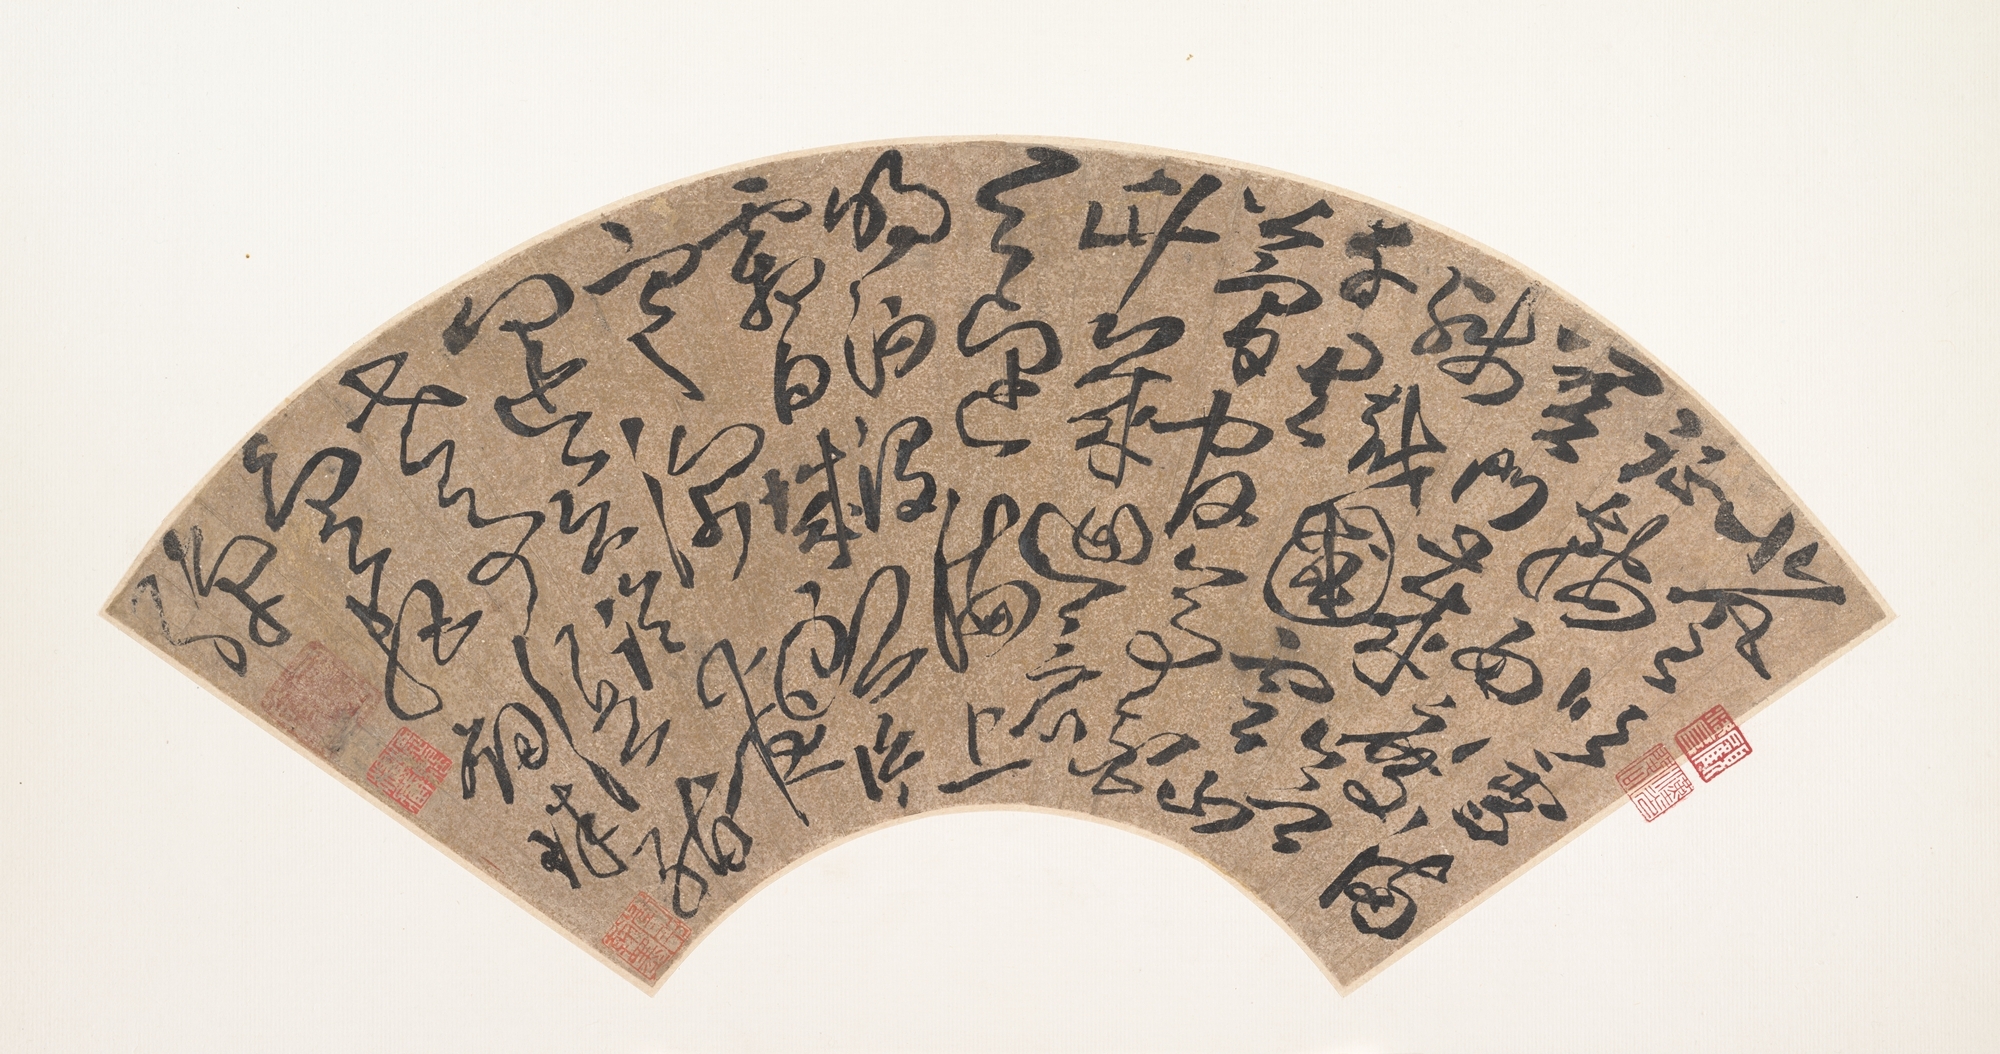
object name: folding fan mounted a an album leaf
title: Winter Journey in the North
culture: chinese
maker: zhu yunming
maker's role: artist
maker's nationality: chinese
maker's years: 1461-1527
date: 1461-1527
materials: gold, ink, paper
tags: calligraphy